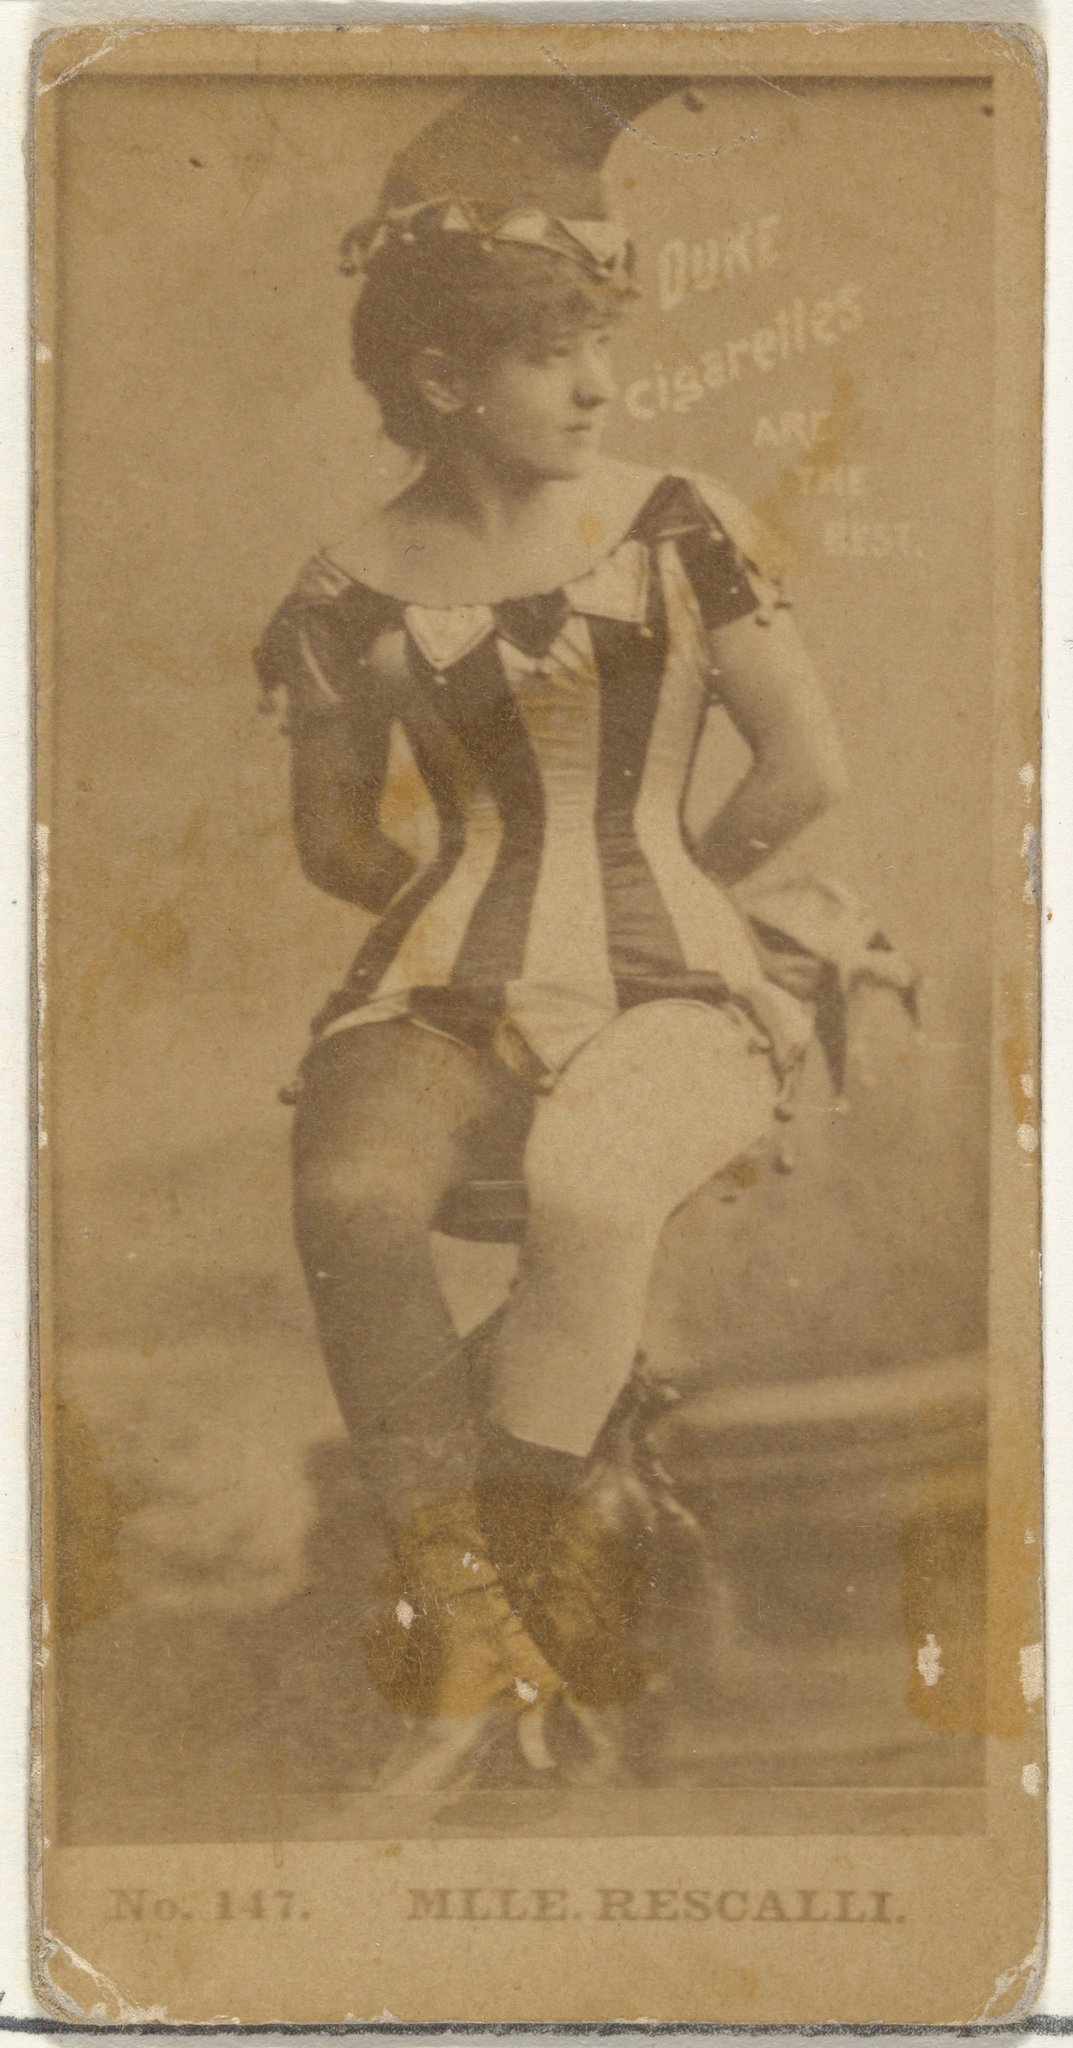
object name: photograph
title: Card Number 147, Mlle. Rescalli, from the Actors and Actresses series (N145-6) issued by Duke Sons & Co. to promote Duke Cigarettes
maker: w. duke, sons & co.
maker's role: publisher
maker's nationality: american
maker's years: 1870-1920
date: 1880-1889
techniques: albumen silver print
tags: portraits,women,actresses